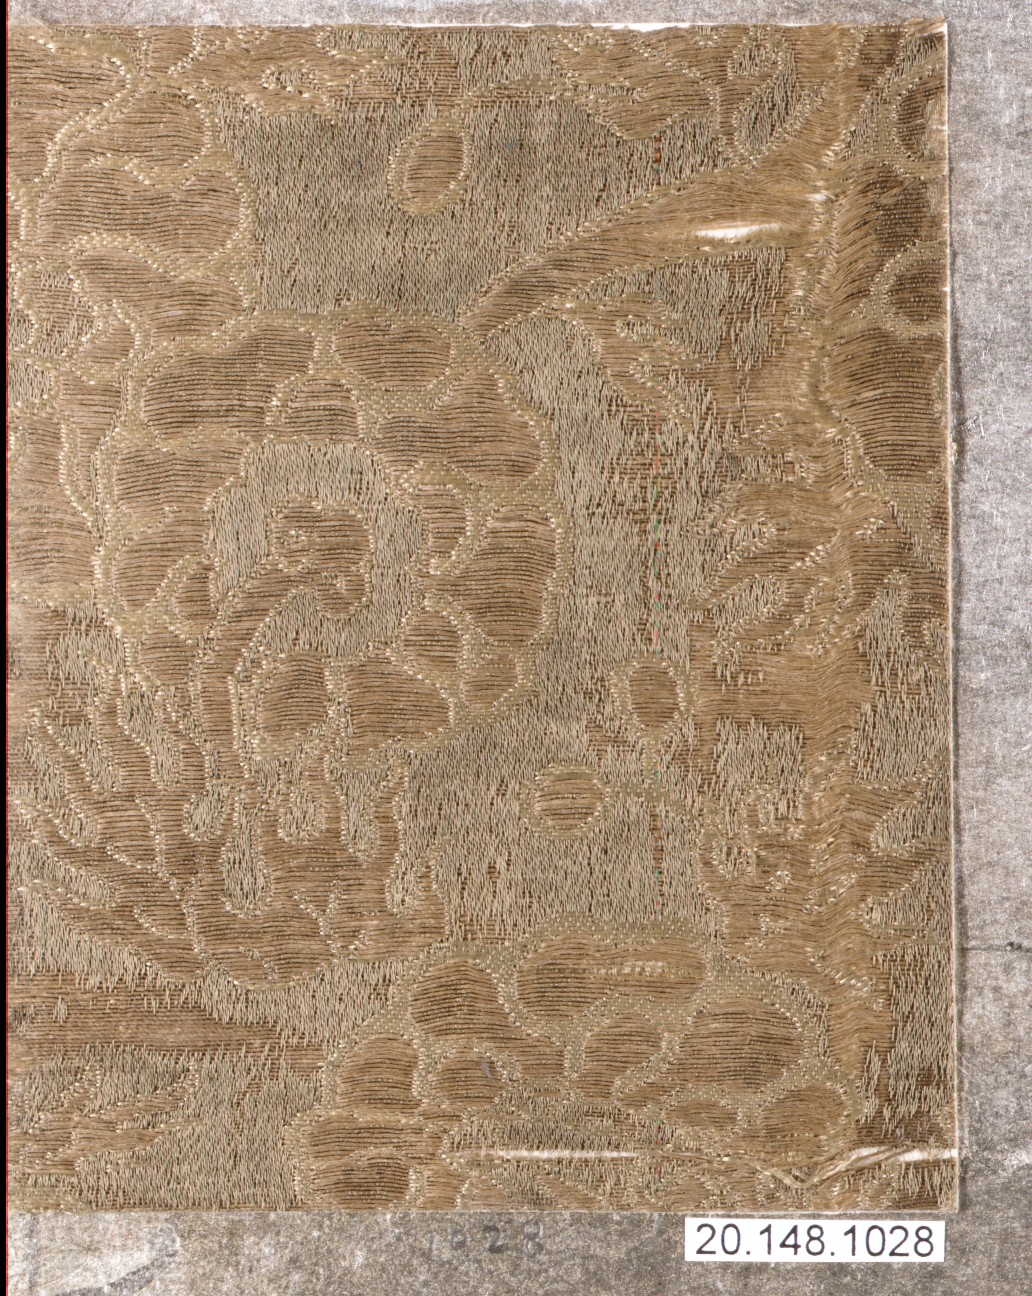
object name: piece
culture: japanese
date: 1701-1800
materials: silk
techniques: compound weave